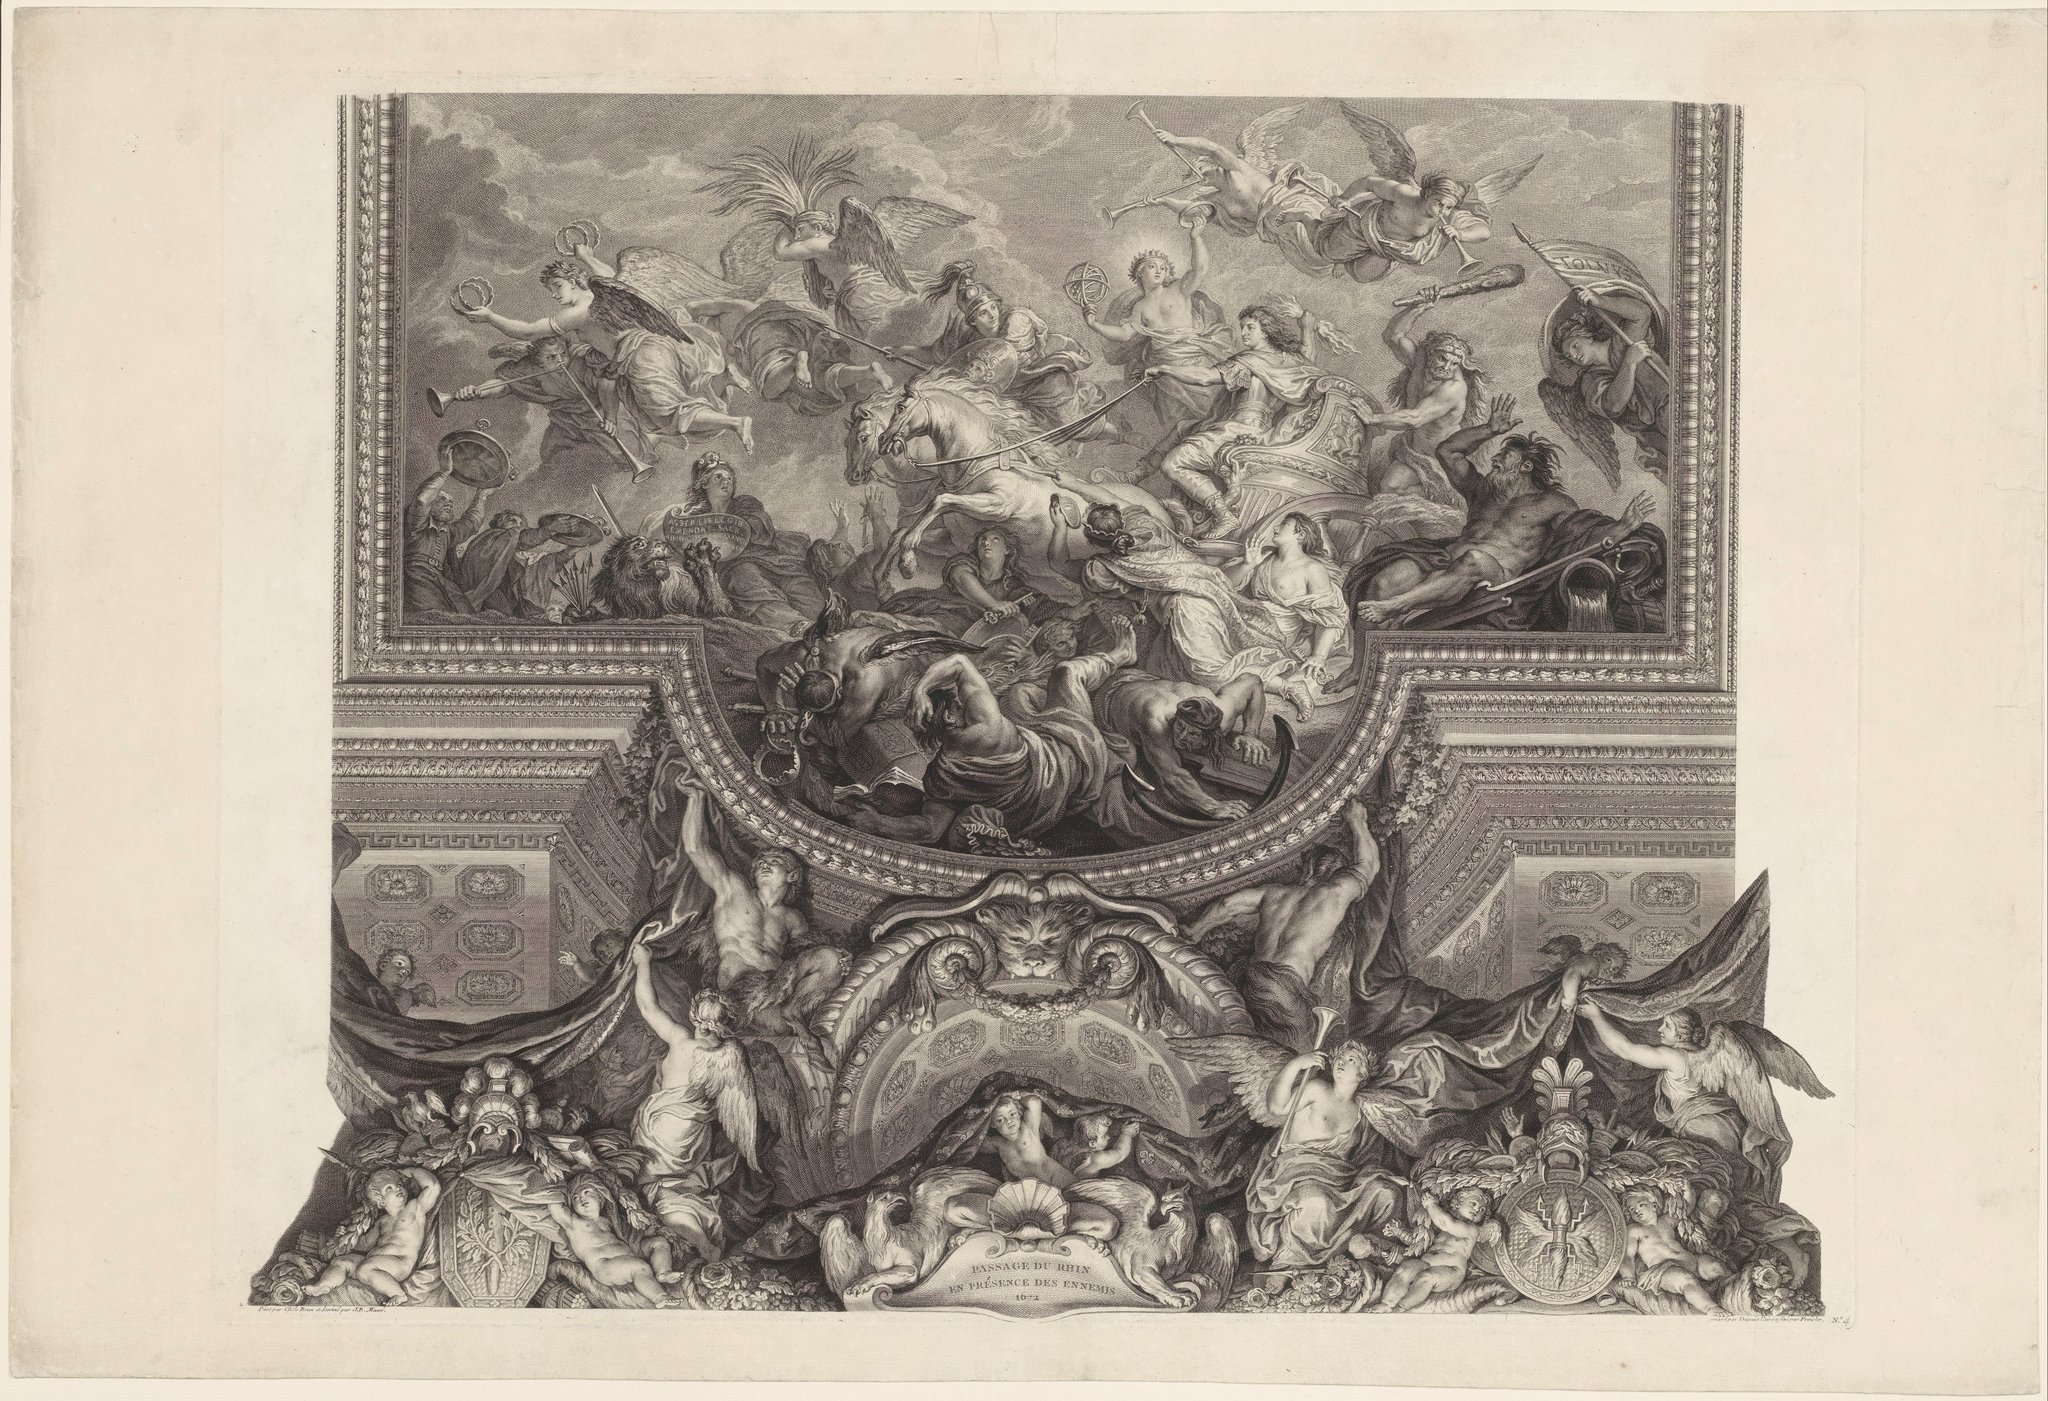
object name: print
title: Passage du Rhin en présence des ennemis, 1672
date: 1752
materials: paper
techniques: engraving, etching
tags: lodewijk xiv (koning van frankrijk), minerva as patroness, river personified, 'fiumi' (ripa)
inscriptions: collector's mark: Lugt 2228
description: Prent gebruikt in: La Grande Galerie de Versailles, et les deux salons qui l'accompagnent, (...). Parijs: Imprimerie Royale, 1752.